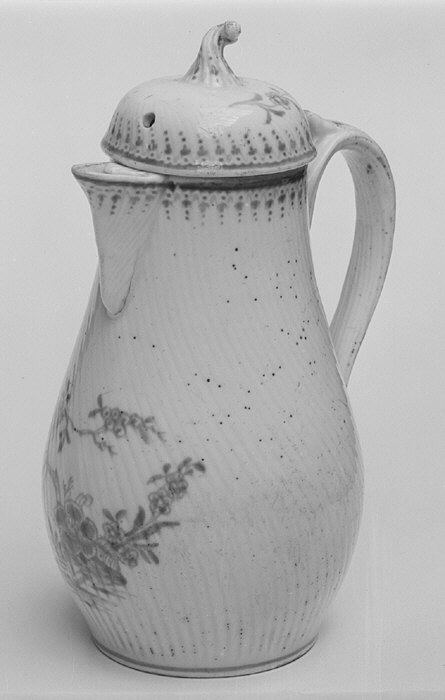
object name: milk pot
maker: tournai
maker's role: factory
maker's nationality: belgian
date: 1770-1775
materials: soft paste porcelain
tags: flowers